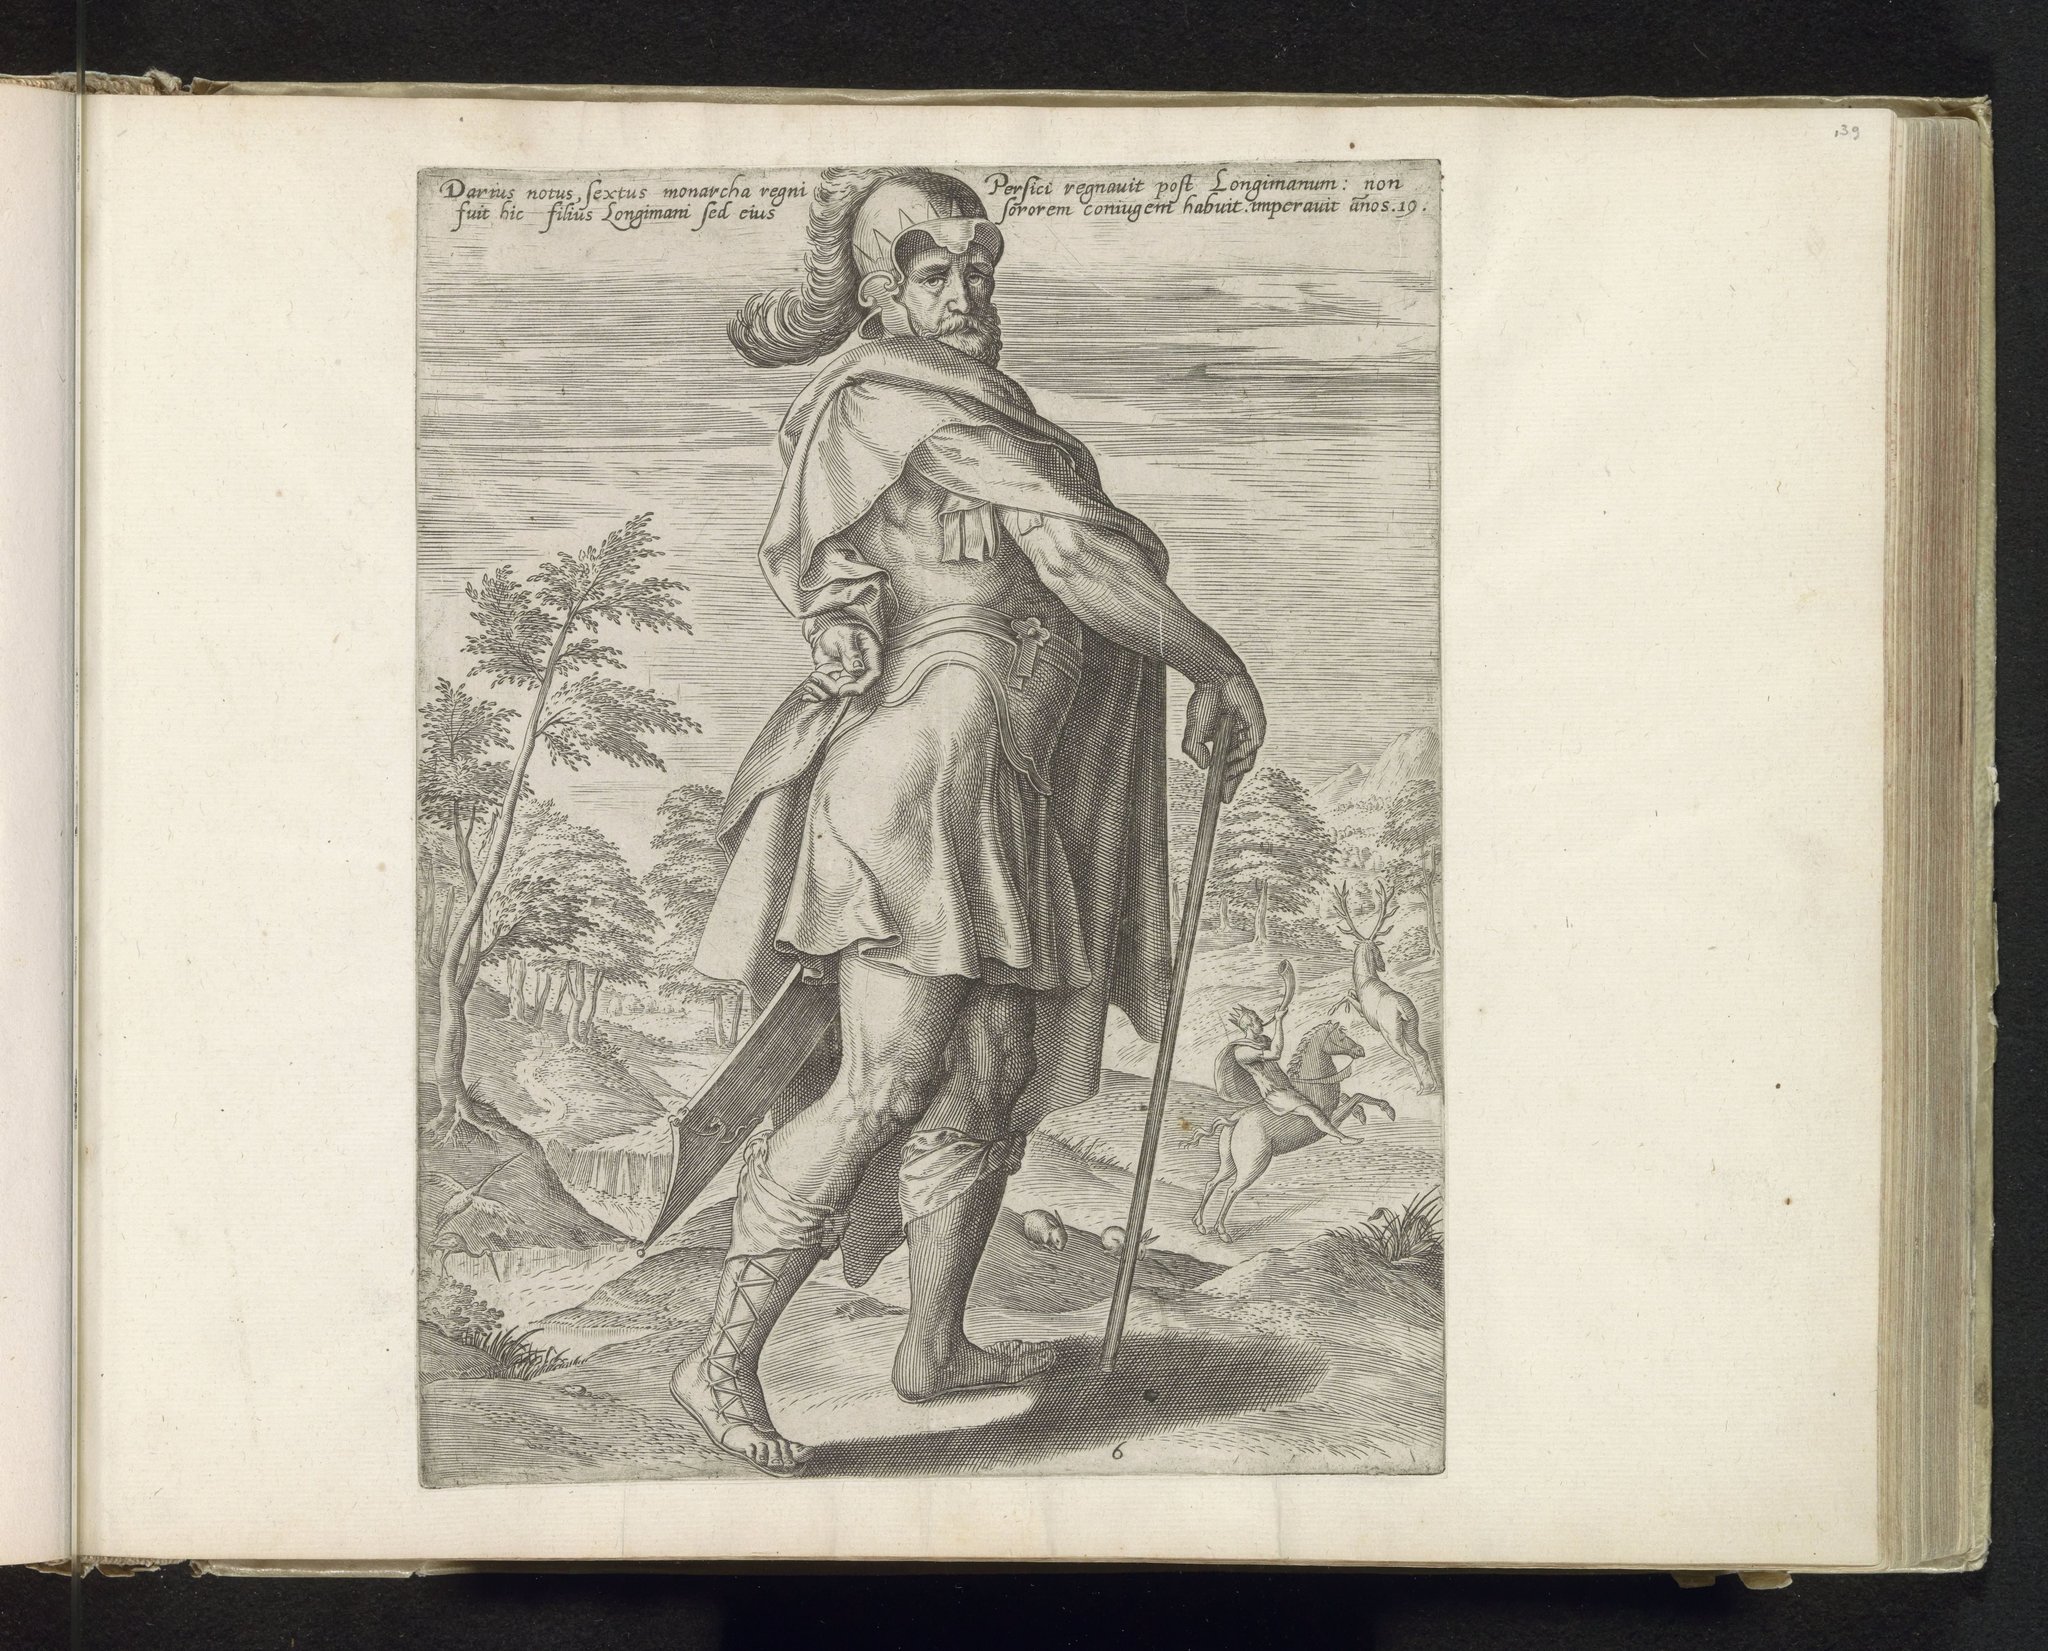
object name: album leaf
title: Koning Darius II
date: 1585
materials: paper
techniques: engraving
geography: antwerp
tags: male persons from classical history, ruler, sovereign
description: Koning Darius II van Perzië staande met een stok in zijn hand. Op de achtergrond een landschap waarin Darius te paard rijdt en op een hert jaagt. Links vogels bij een waterval. Boven de voorstelling een tweeregelige tekst in het Latijn. Deze prent maakt deel uit van een album.